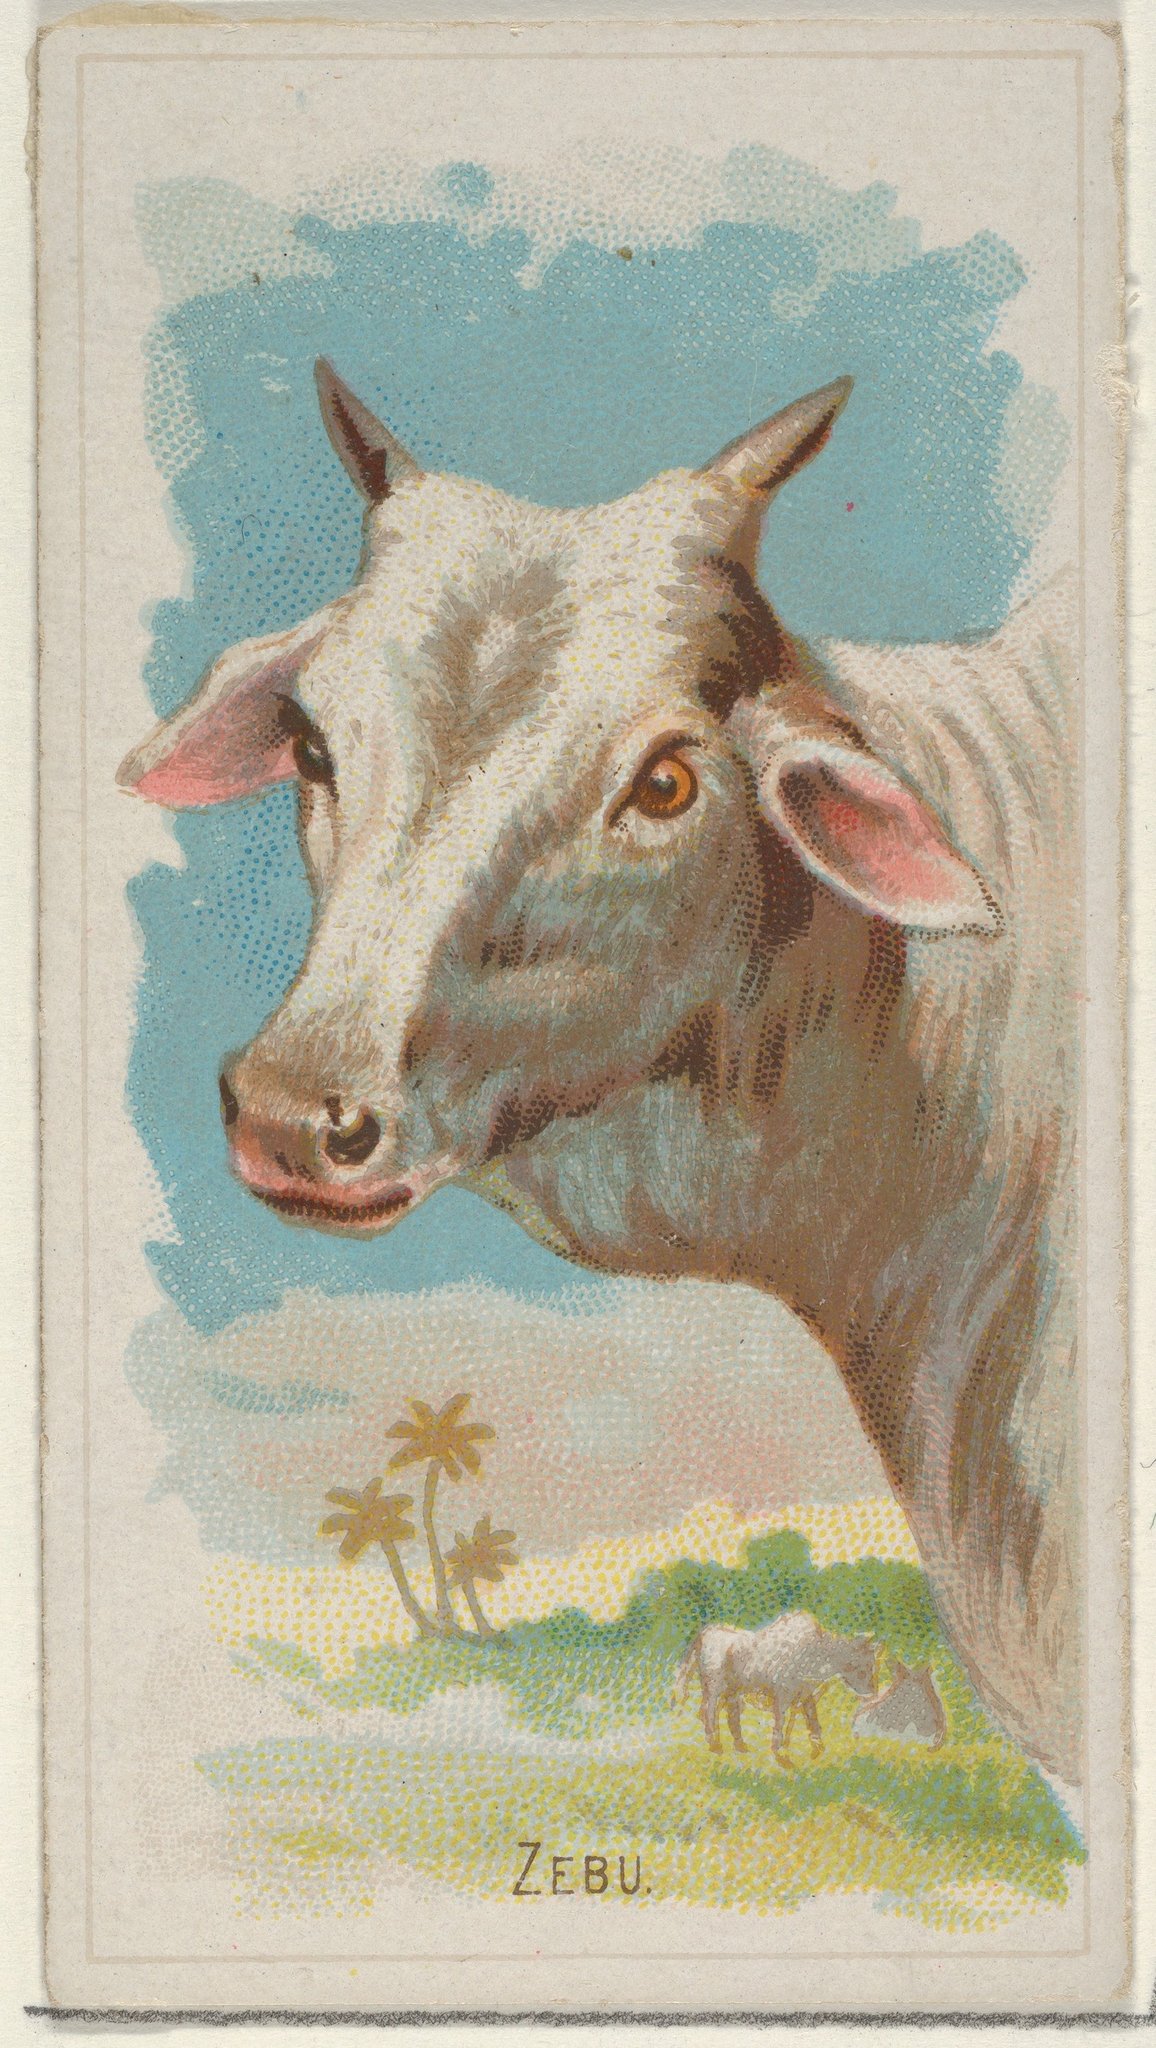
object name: print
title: Zebu, from the Wild Animals of the World series (N25) for Allen & Ginter Cigarettes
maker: allen & ginter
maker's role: publisher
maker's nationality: american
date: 1888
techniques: color lithograph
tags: animals